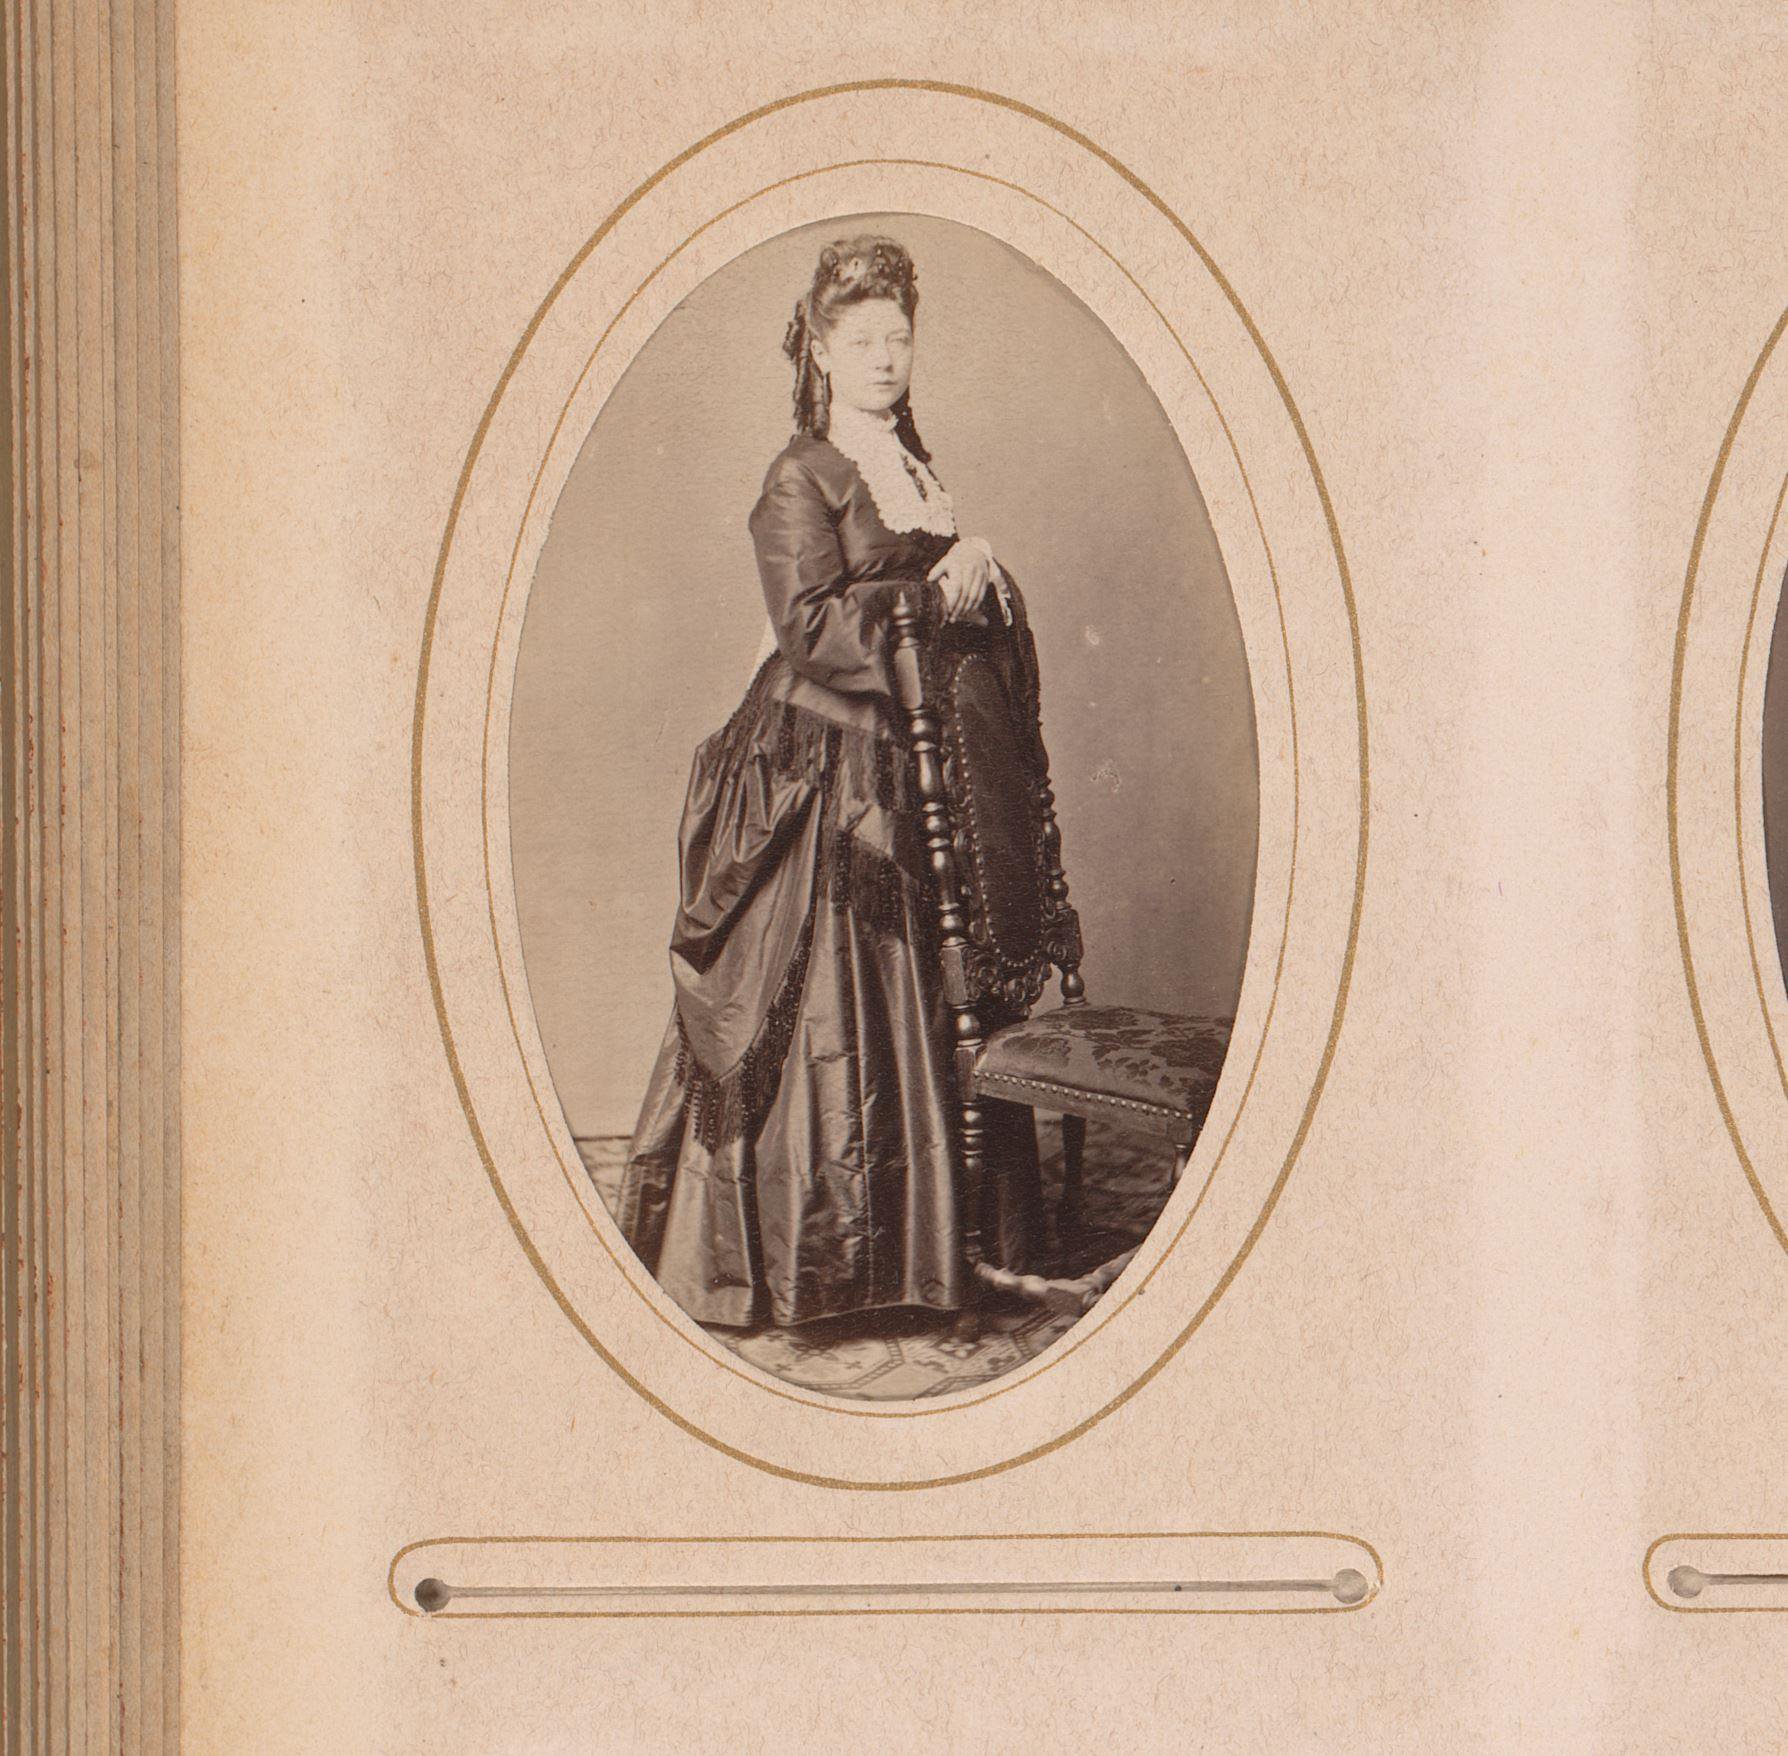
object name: photograph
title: Portret van een vrouw, staand bij een stoel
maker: dirk le grand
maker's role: artist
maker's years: 1819-1891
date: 1872-1891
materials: cardboard, photographic support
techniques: albumen print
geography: breda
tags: historical persons - bb - woman, standing figure - aa - female human figure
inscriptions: inscription: ‘Photographie/ D. le Grand/ Hoek Bosch en Brouwerijstraat D. 234/ Breda’